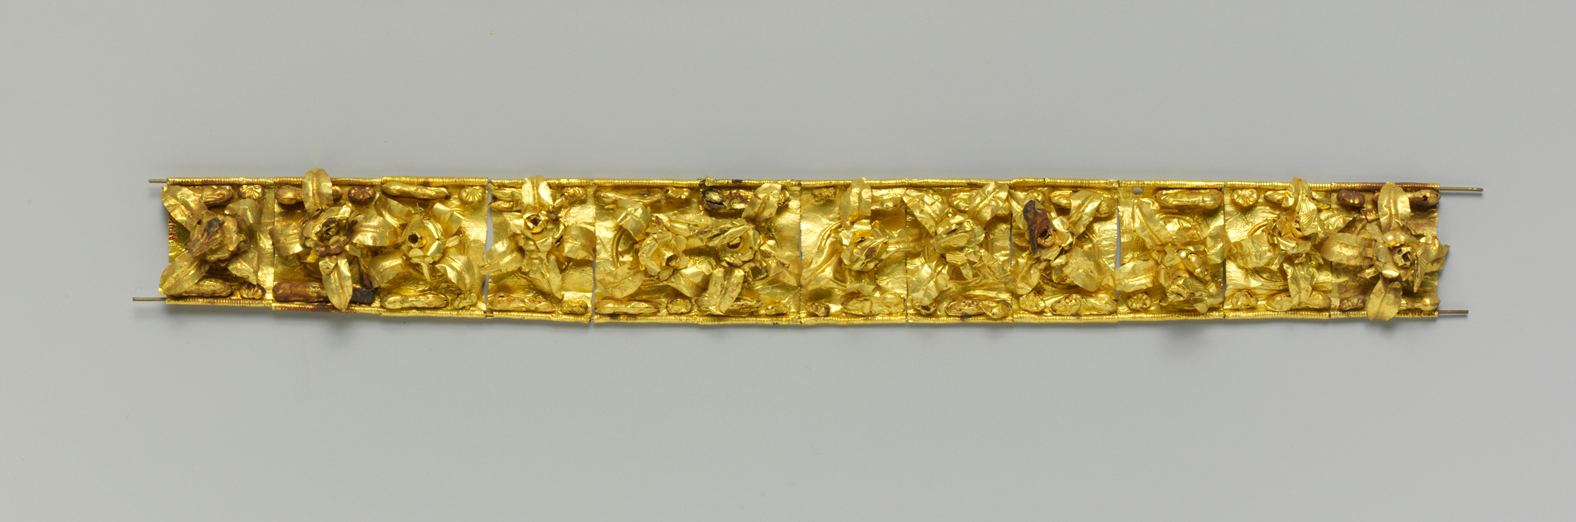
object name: gold diadem composed of twelve plaque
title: Gold diadem composed of twelve plaques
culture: etruscan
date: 500-301 BCE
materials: gold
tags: birds,diadems,flowers